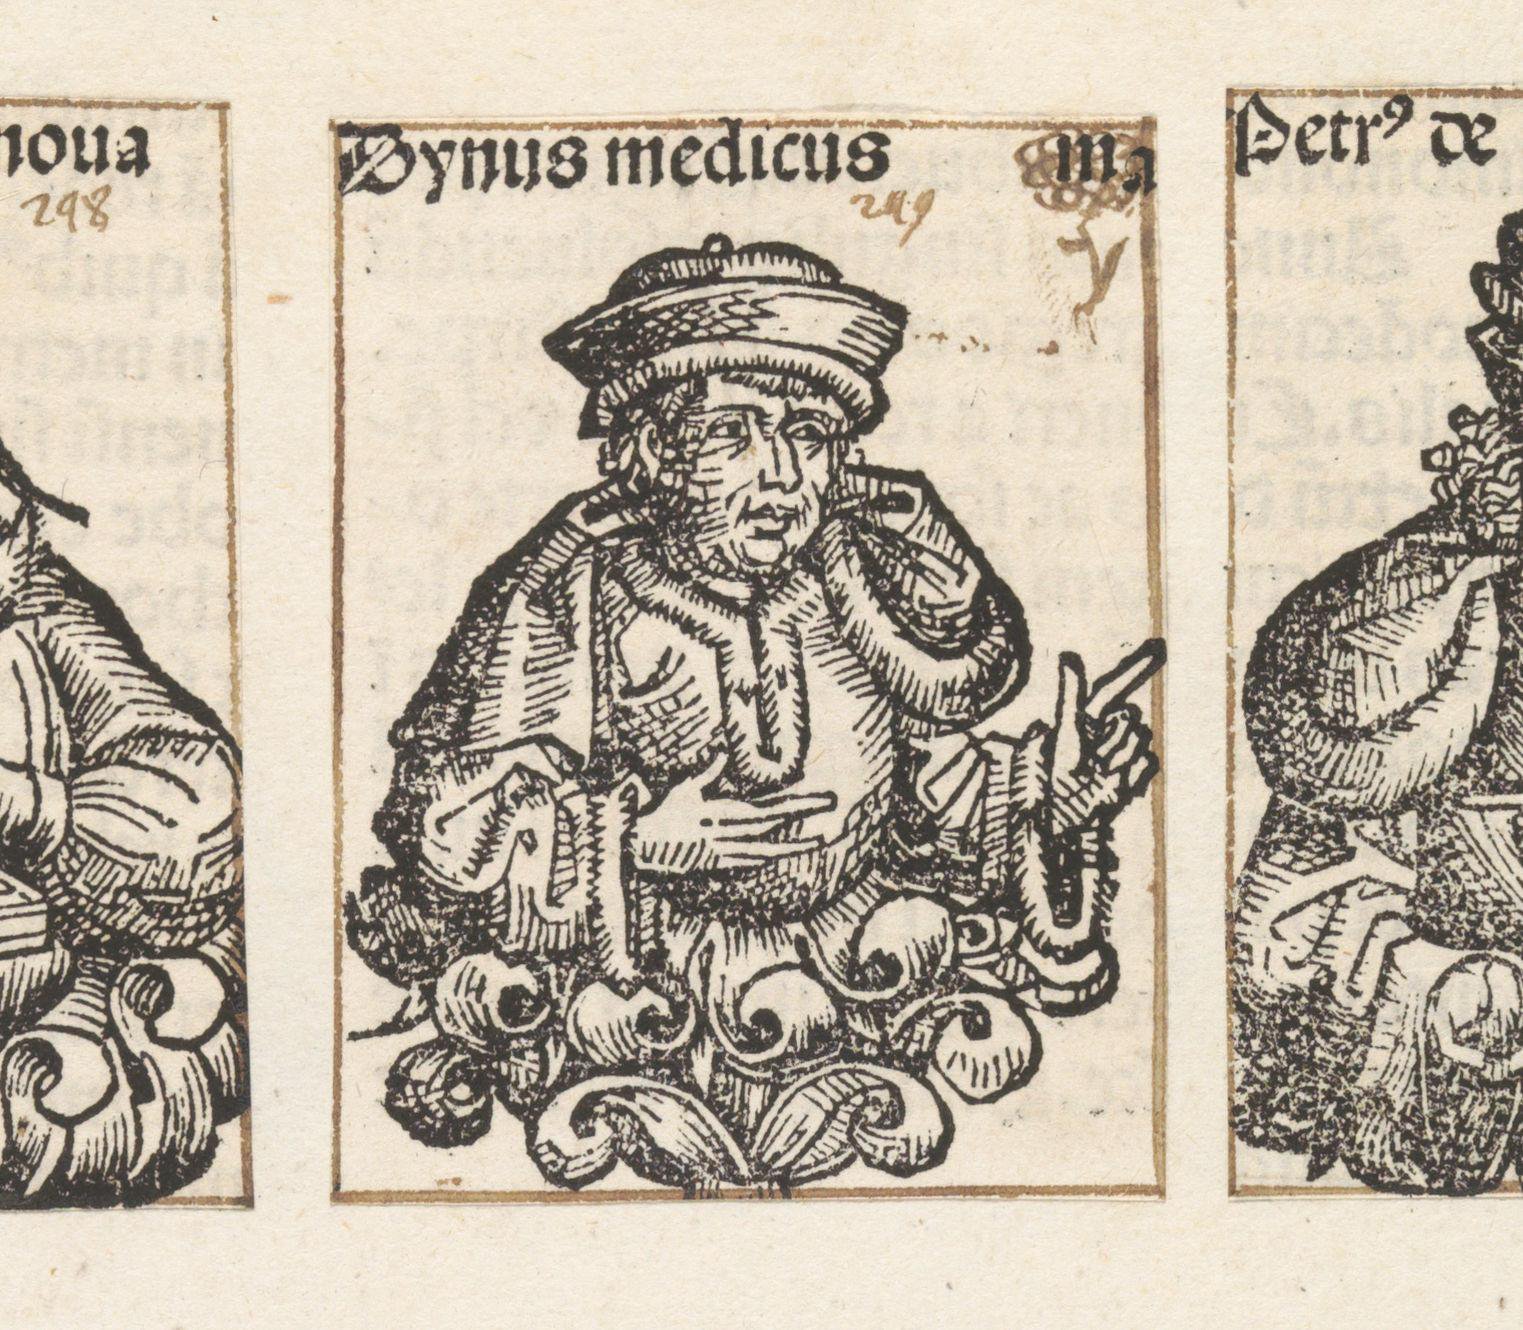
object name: album leaf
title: Liber Chronicarum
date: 1493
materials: paper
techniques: letterpress printing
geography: nuremberg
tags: florence, filosoof, arts, dino del garbo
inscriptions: inscription: ‘249’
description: De houtsnede wordt herhaaldelijk gebruikt als boekillustratie in de Liber Chronicarum (of Neurenbergkroniek) van Hartmann Schedel, verschenen in het Latijn en Duits in 1493. Zie de Latijnse uitgave, folio 224r.